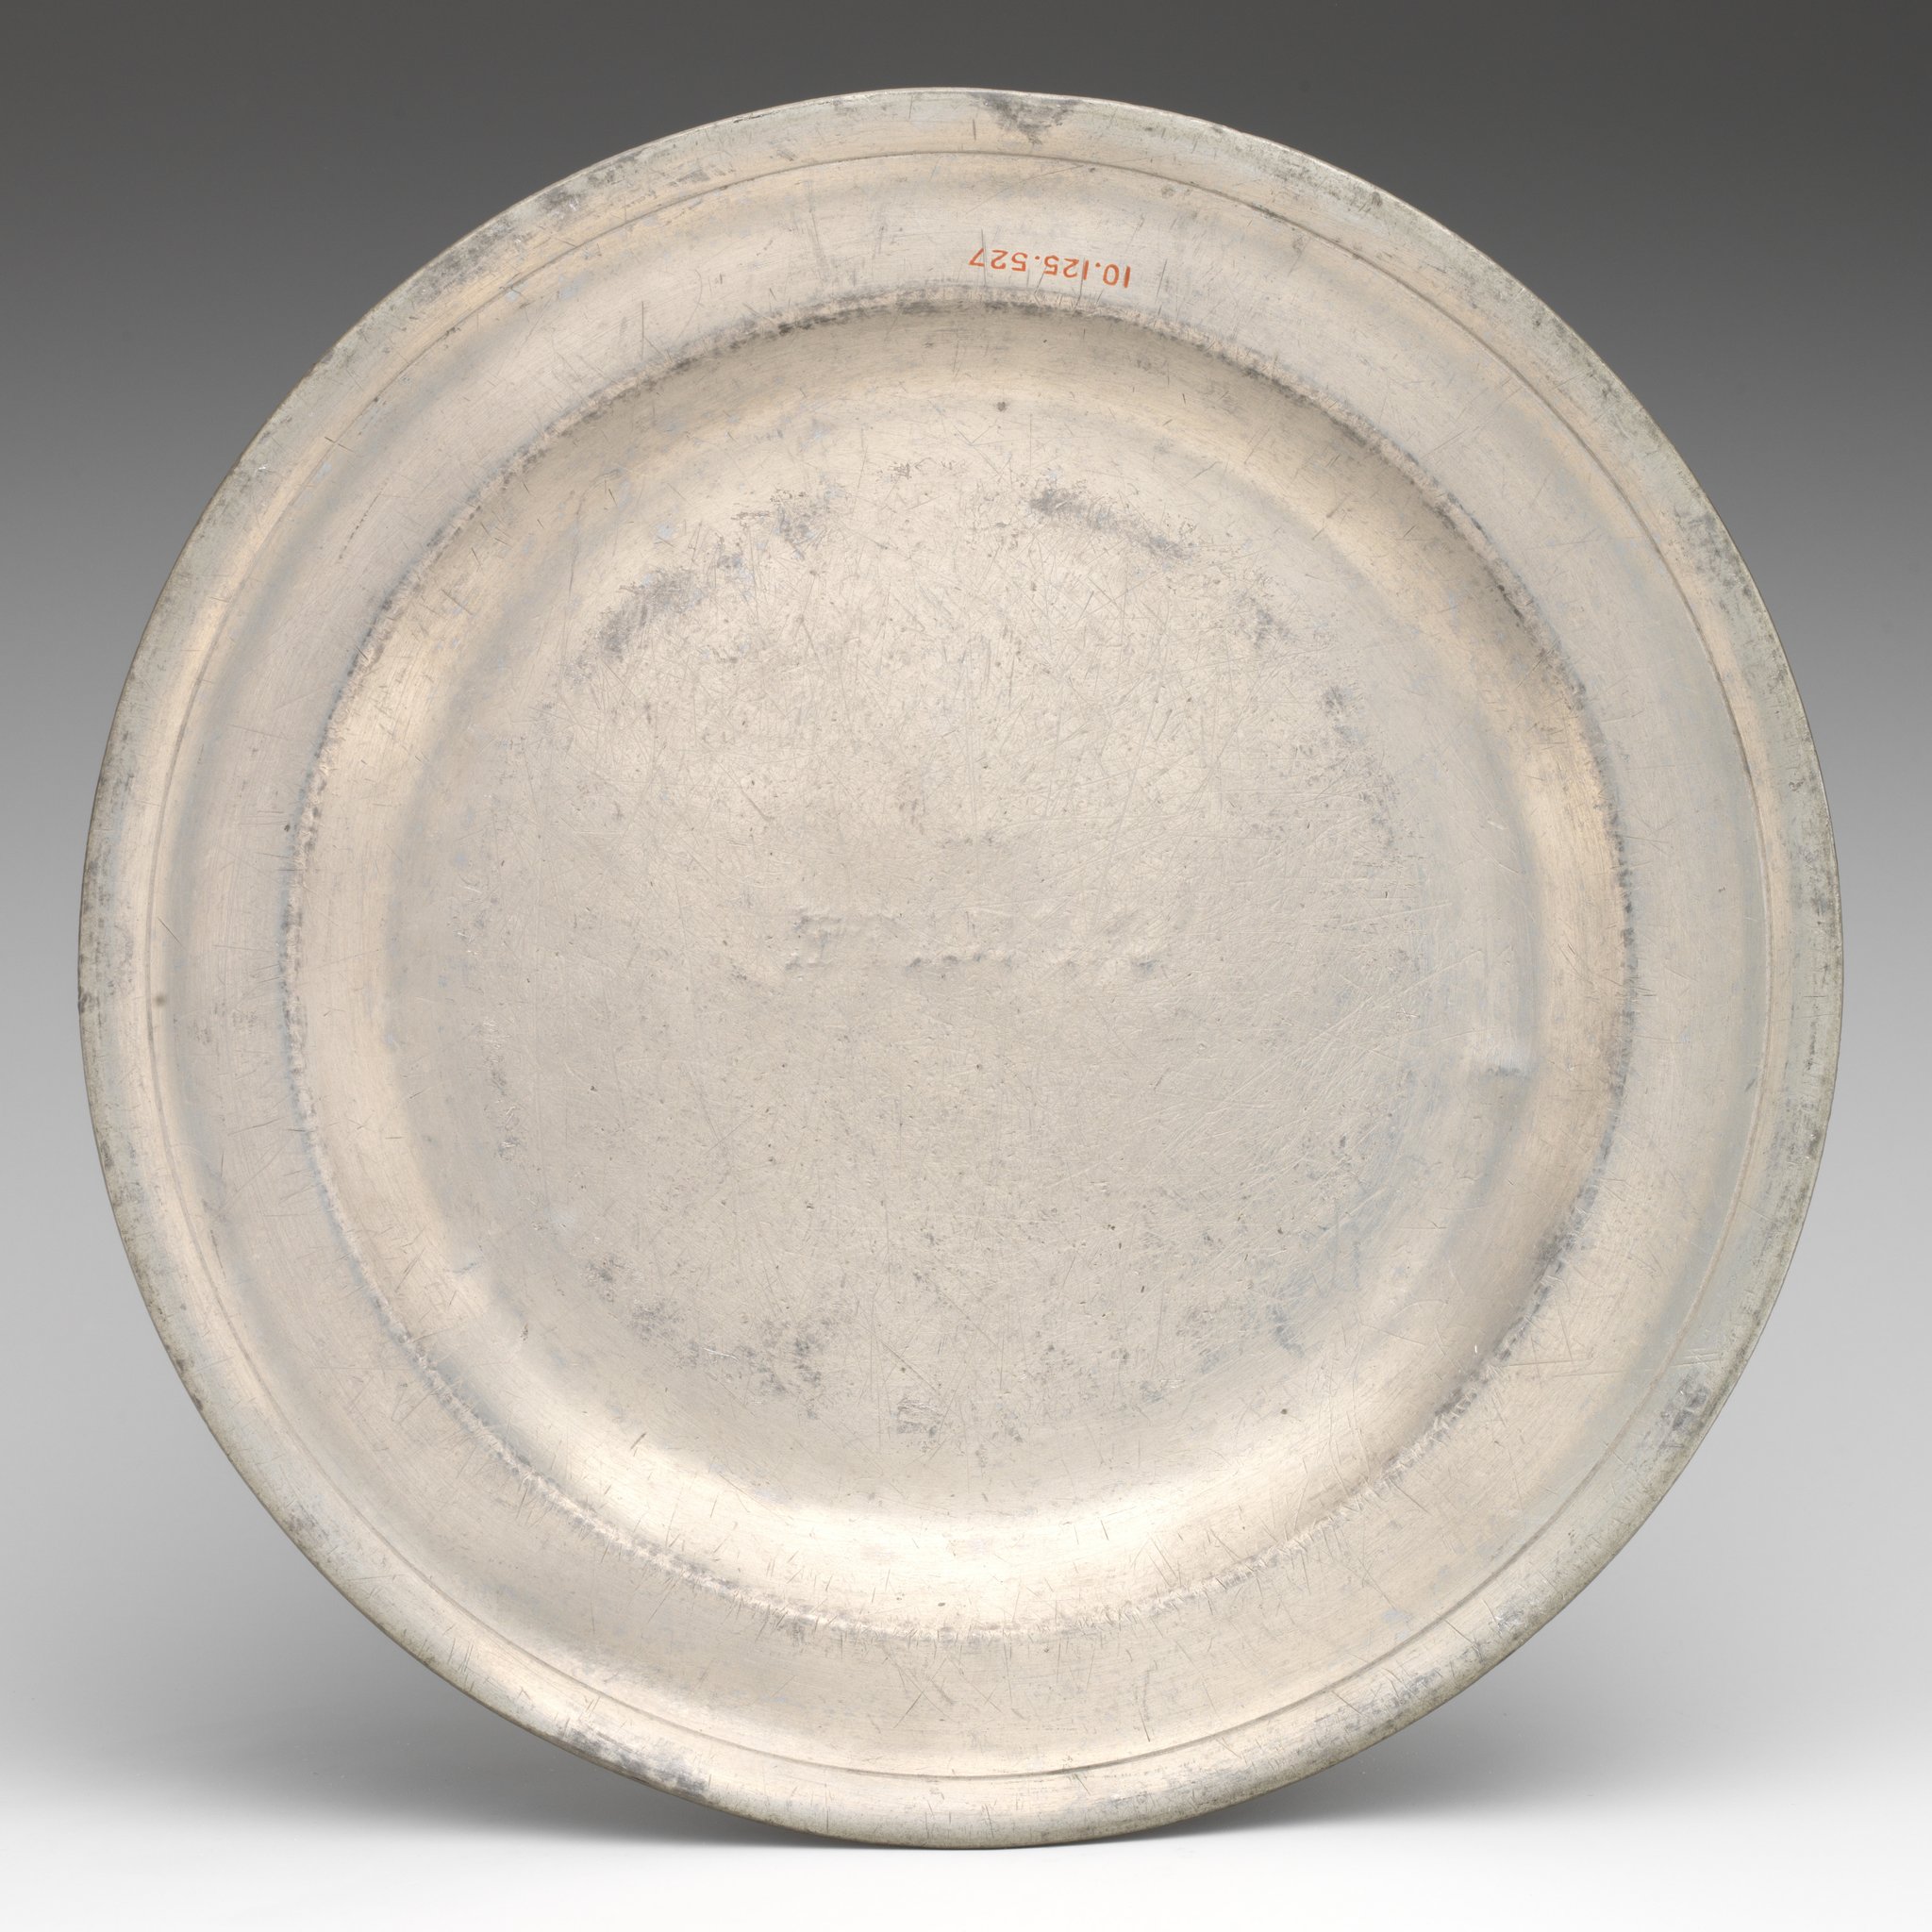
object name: plate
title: Plate (part of a set)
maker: robert l. bush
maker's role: maker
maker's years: 1725-1825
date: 1781-1793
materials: pewter